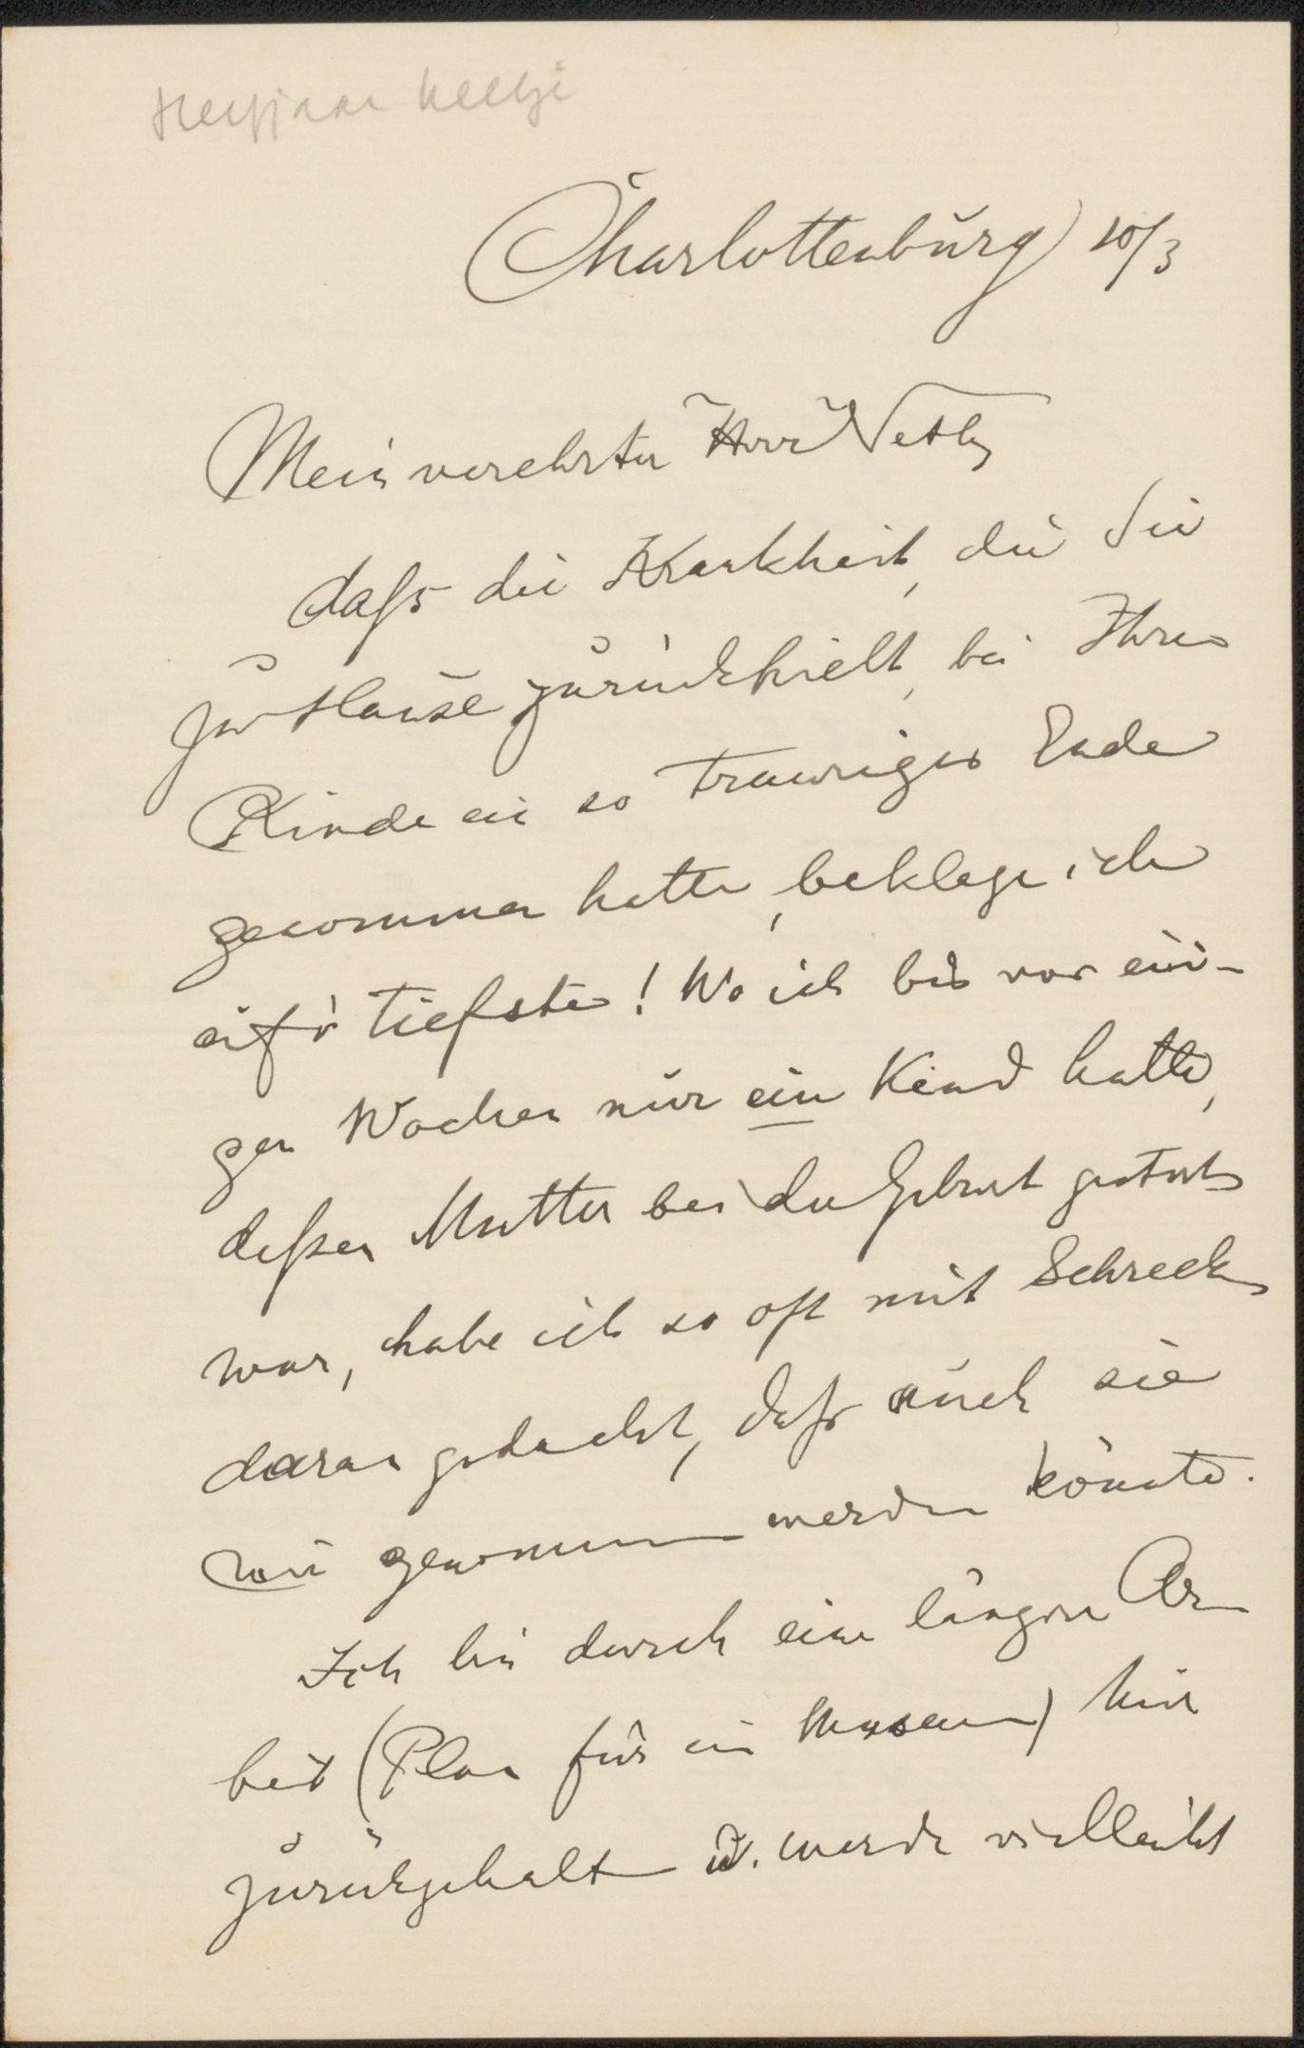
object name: letter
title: Brief aan Jan Veth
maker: wilhelm von bode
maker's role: conservator, kunsthistoricus, museumdirecteur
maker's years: 1845-1929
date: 1874-1925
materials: ink, paper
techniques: pen, writing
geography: charlottenburg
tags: amsterdam, painter, draughtsman, designer, jan veth, family life, diseases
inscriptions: watermark, collector's mark: ‘RPK’